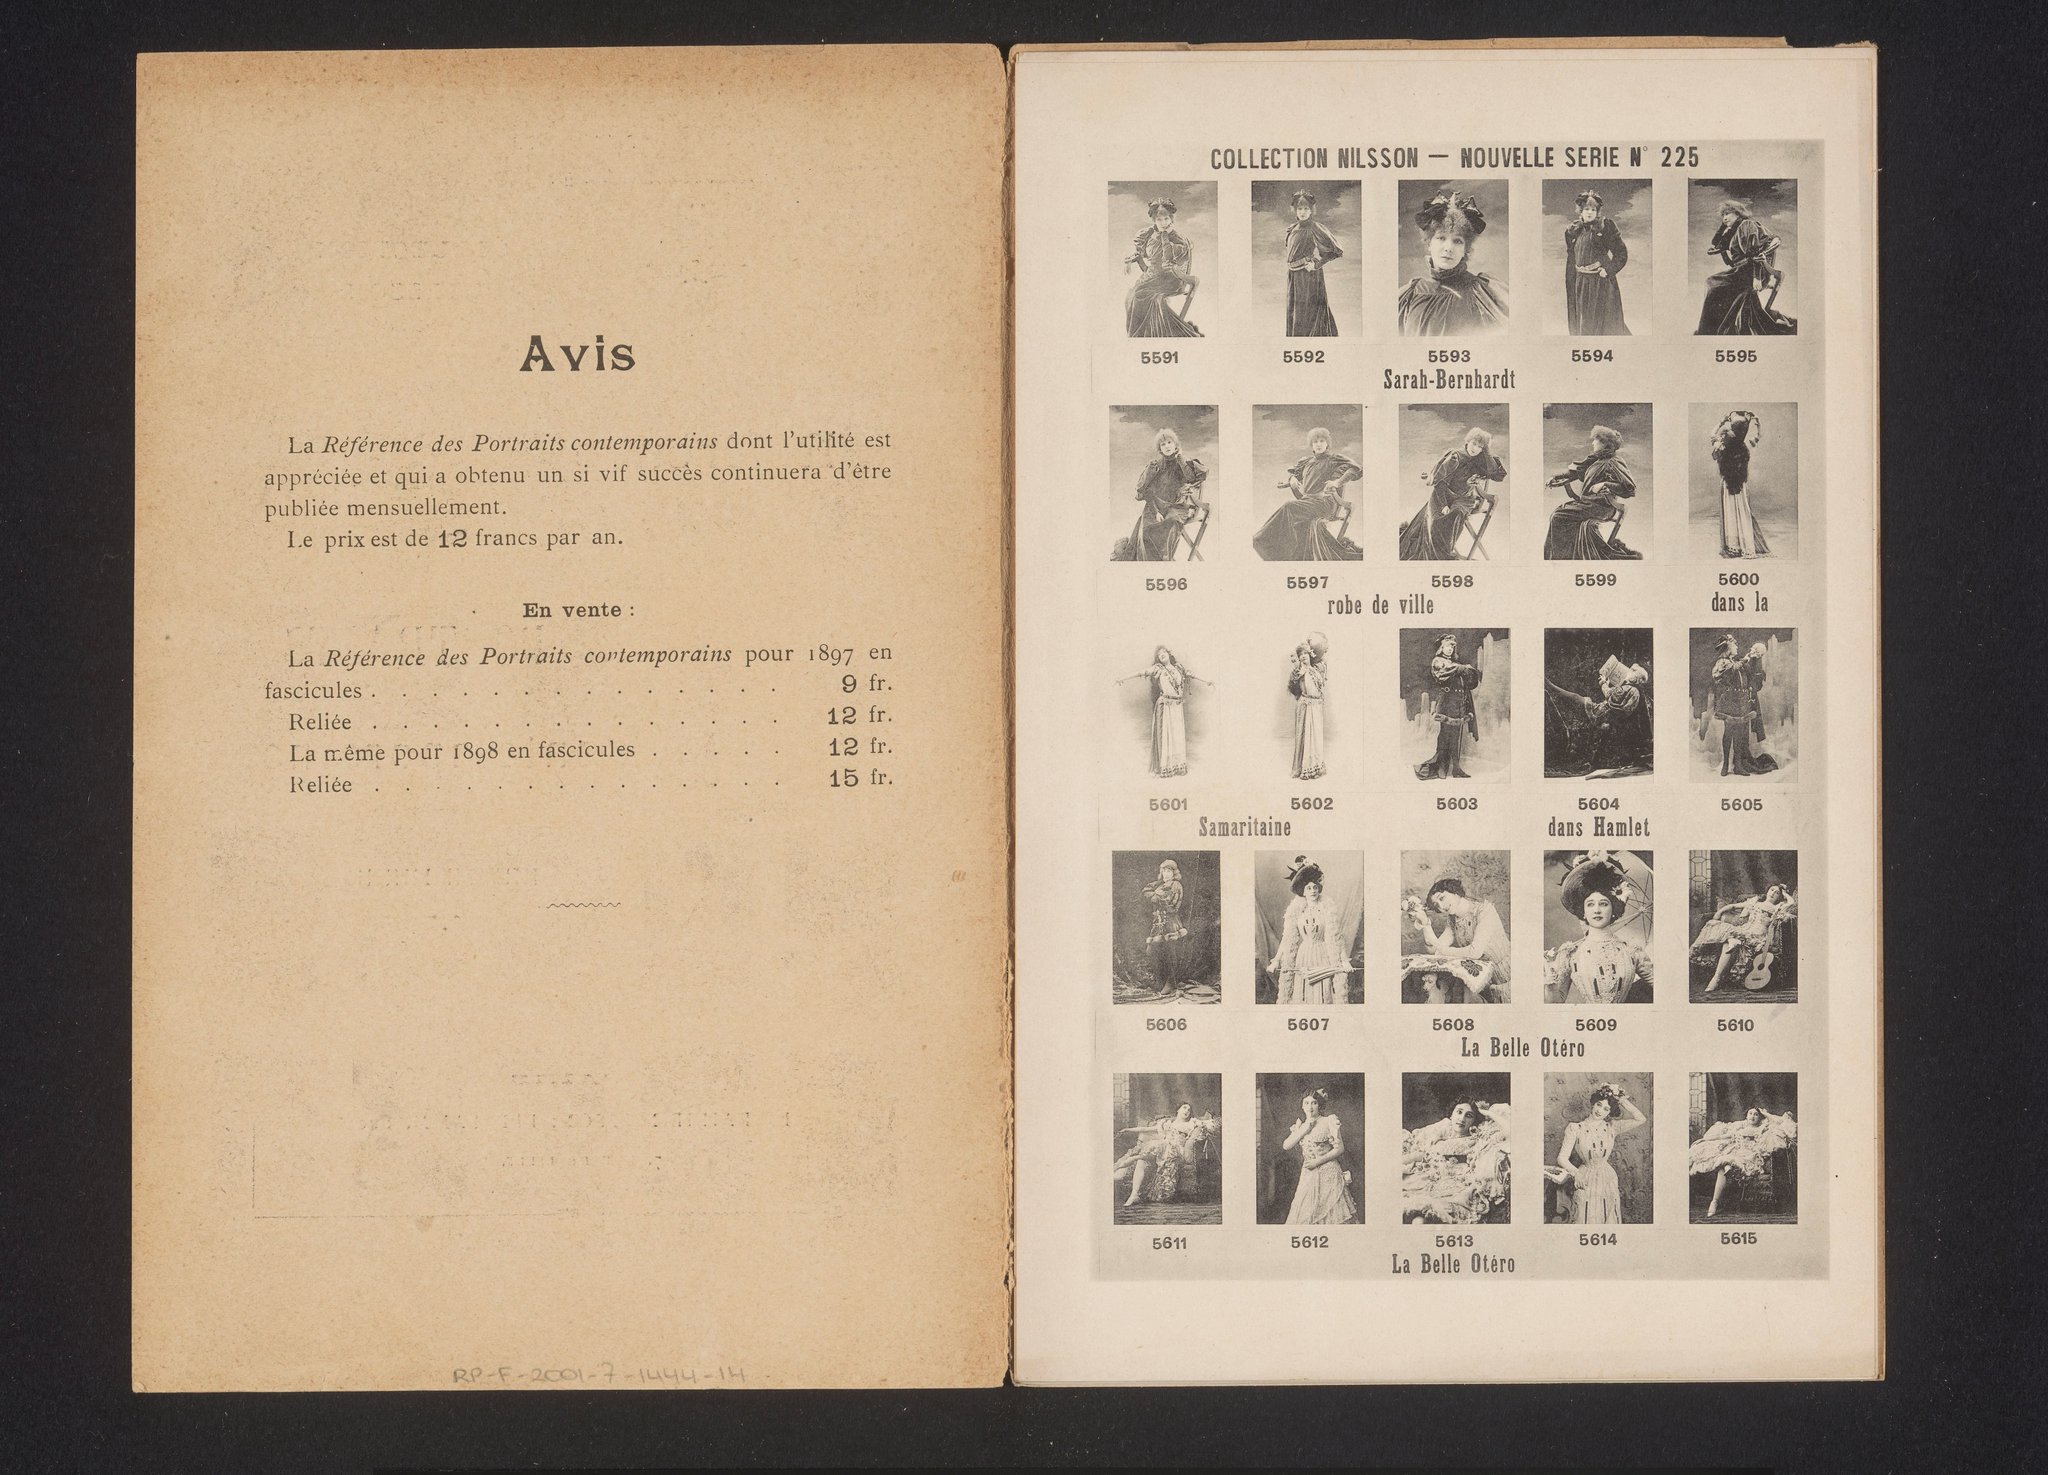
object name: photomechanical print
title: 25 portretten van Sarah Bernhardt en La Belle Otero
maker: Anonymous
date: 1894-1899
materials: paper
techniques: photograph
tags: paris, sculptor, sarah bernhardt, historical persons - bb - woman, portrait of actor, actress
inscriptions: inscription: ‘Sarah-Bernhardt/ robe de ville dans la/ Samaritaine dans Hamlet/ La Belle Otéro/ La Belle Otéro’, number: ‘No 225’